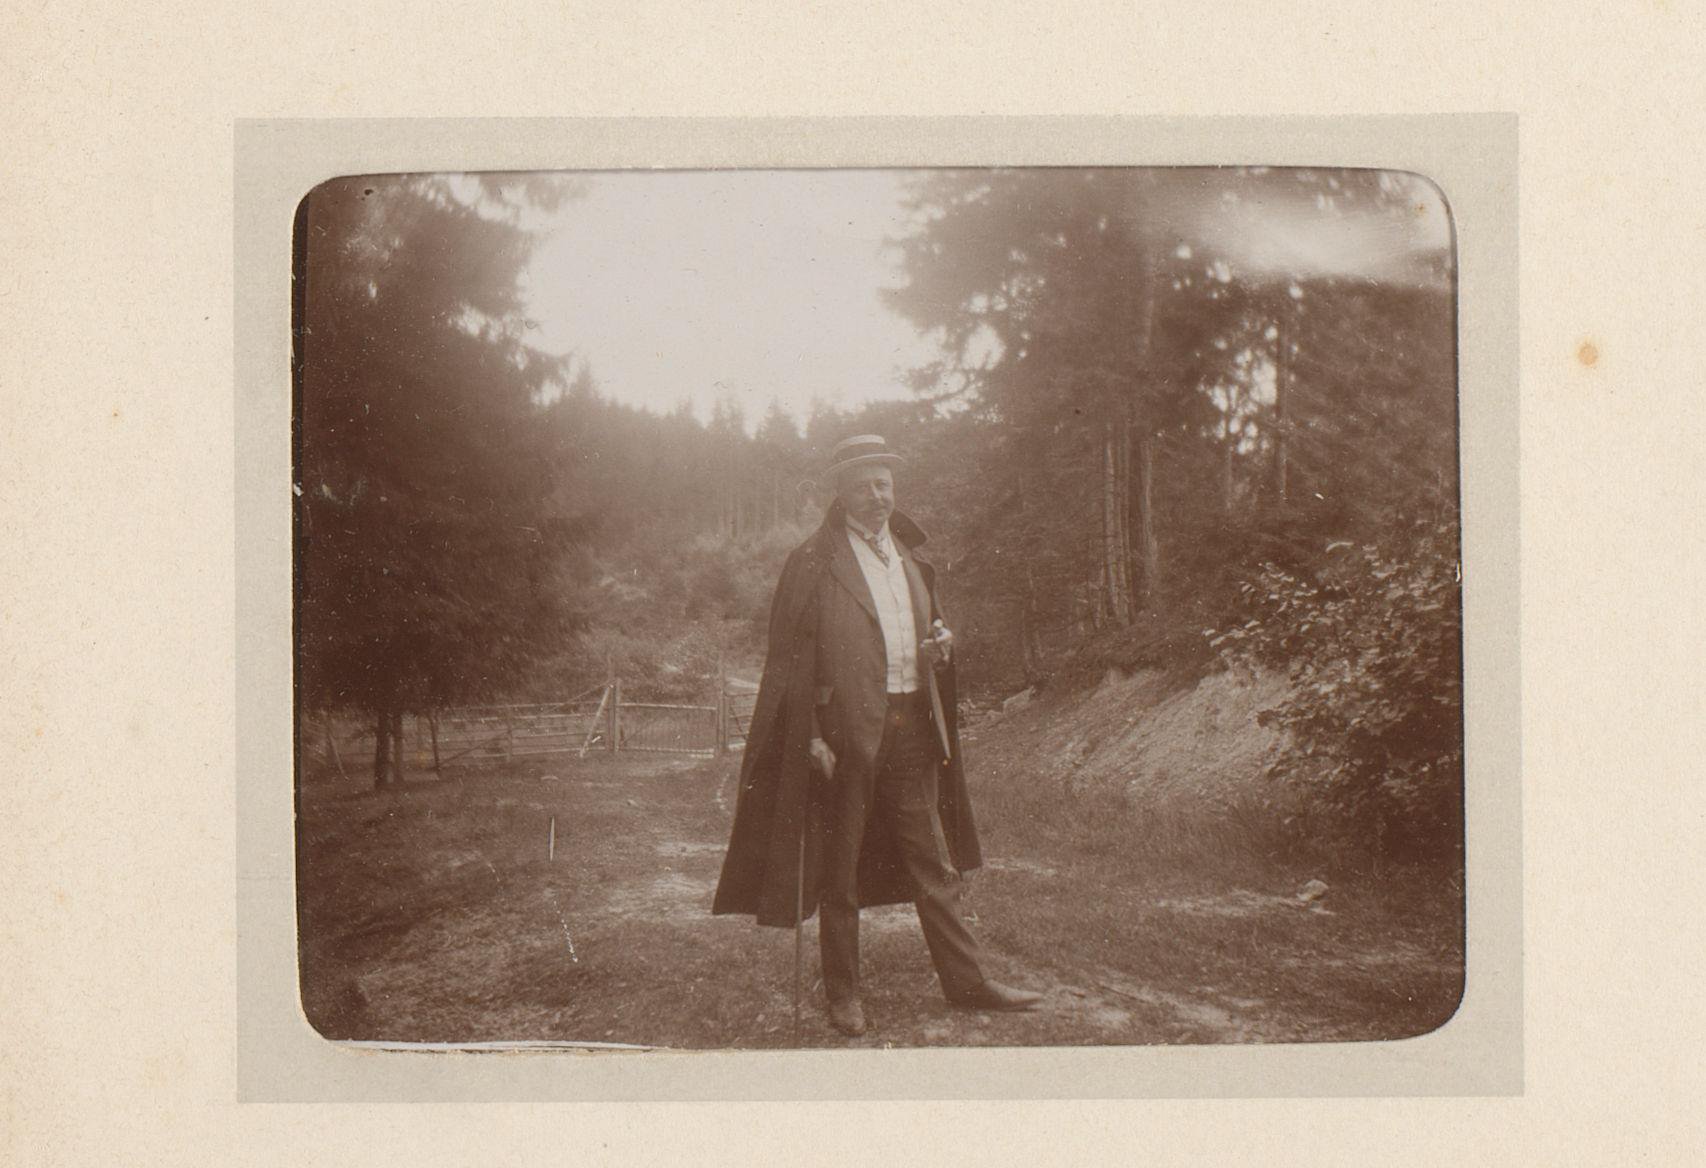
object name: photograph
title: Portret van een man met sigaar en overjas in een bergwei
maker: liesbeth overhoff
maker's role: fotograaf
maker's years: 1895-1969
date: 1910-1915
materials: paper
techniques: collodion silver print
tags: cigar, cape, historical persons, meadow, pasture